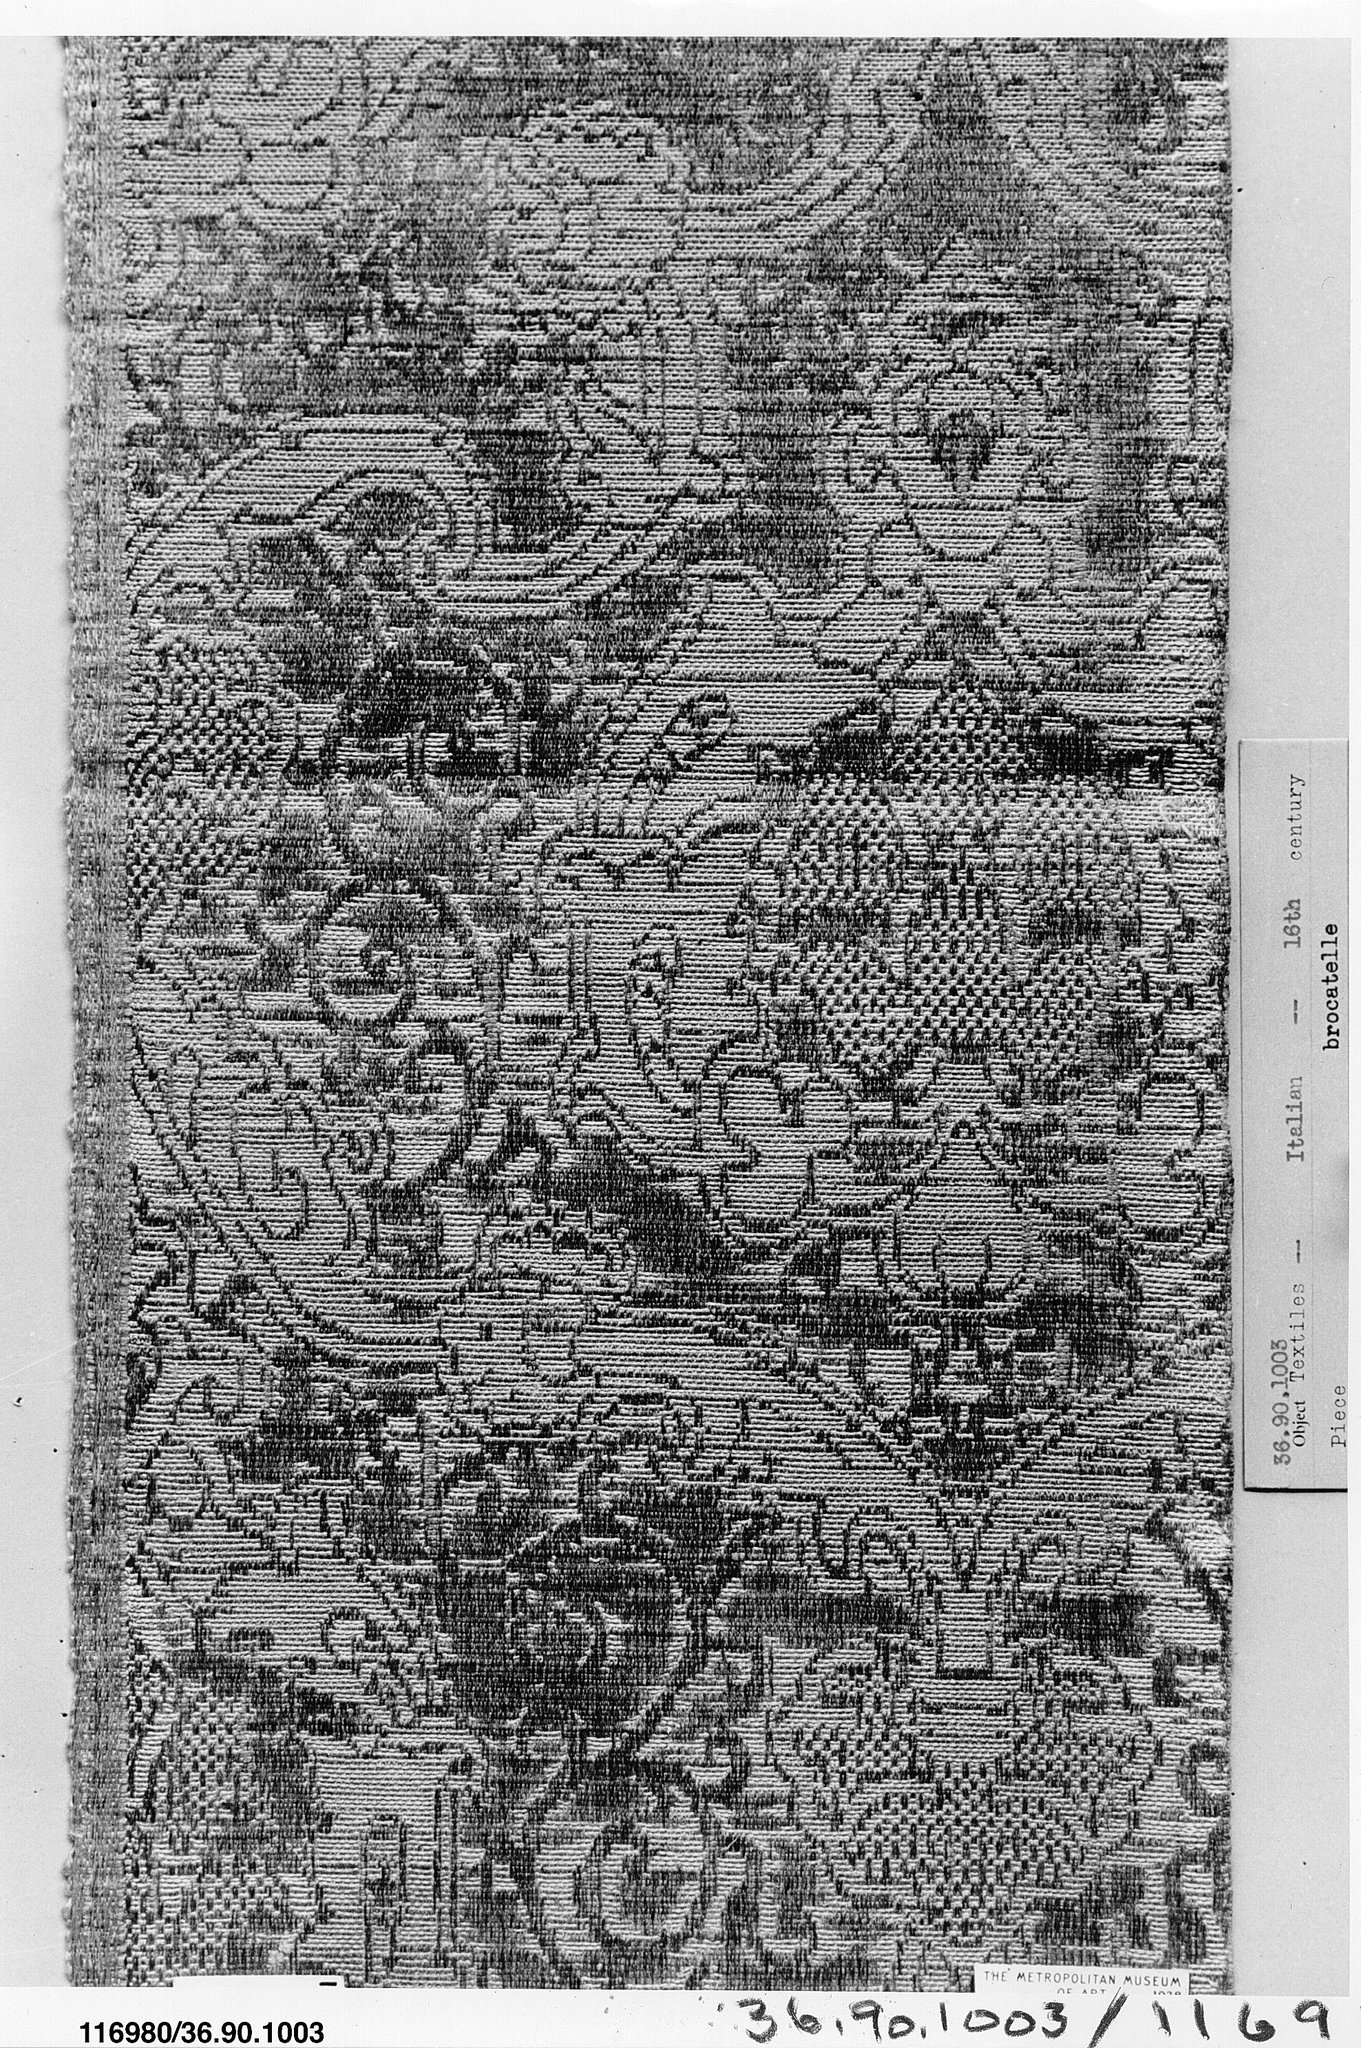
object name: piece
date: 1501-1600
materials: cotton, silk